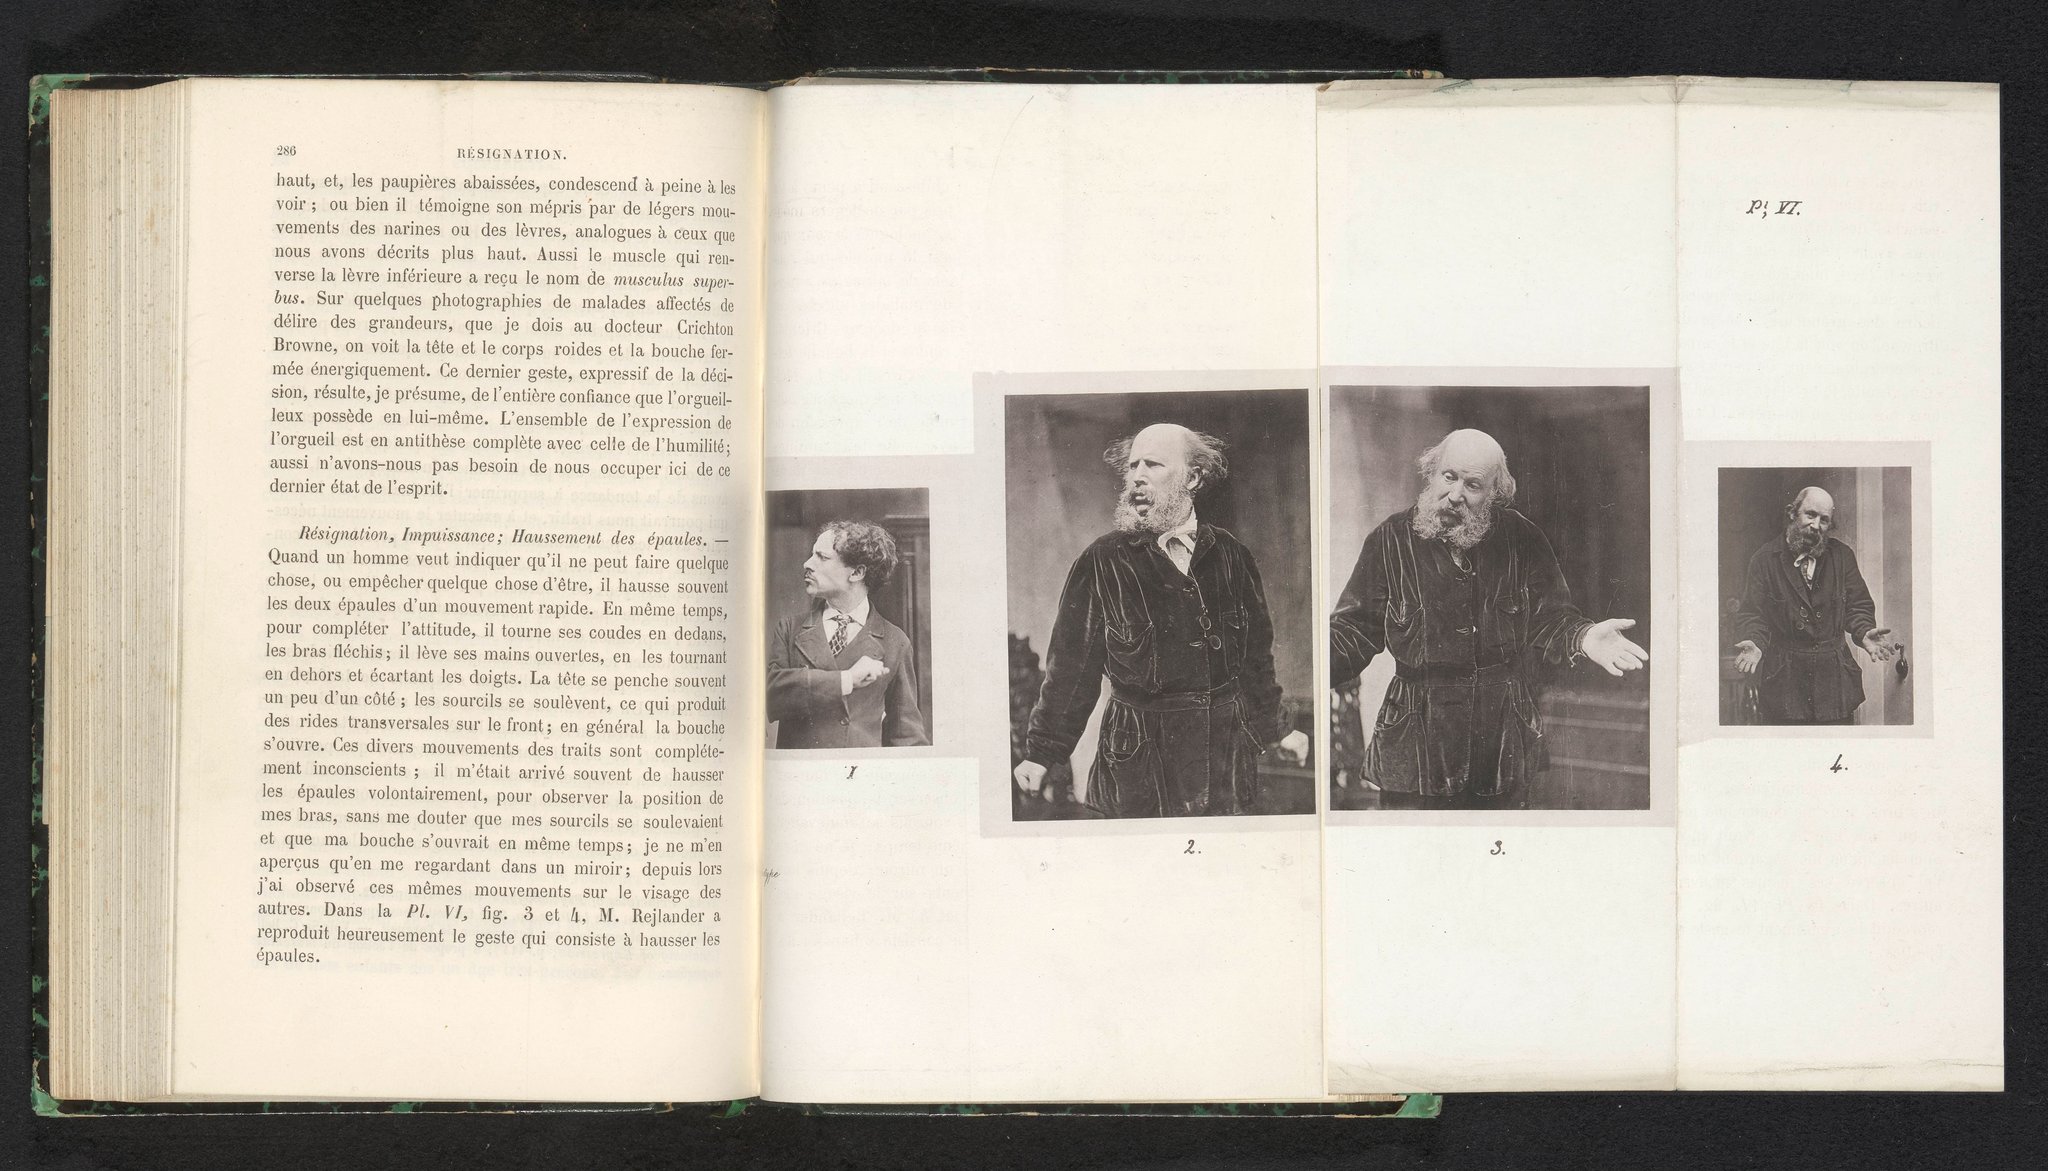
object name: page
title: Vier mannen, gerangschikt van woede naar overgave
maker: Anonymous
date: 1868-1874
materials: paper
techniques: photograph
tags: calmness, equanimity, imperturbability, rage, anger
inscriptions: number: ‘1. (...) 4.’, number: ‘Pt. VI’